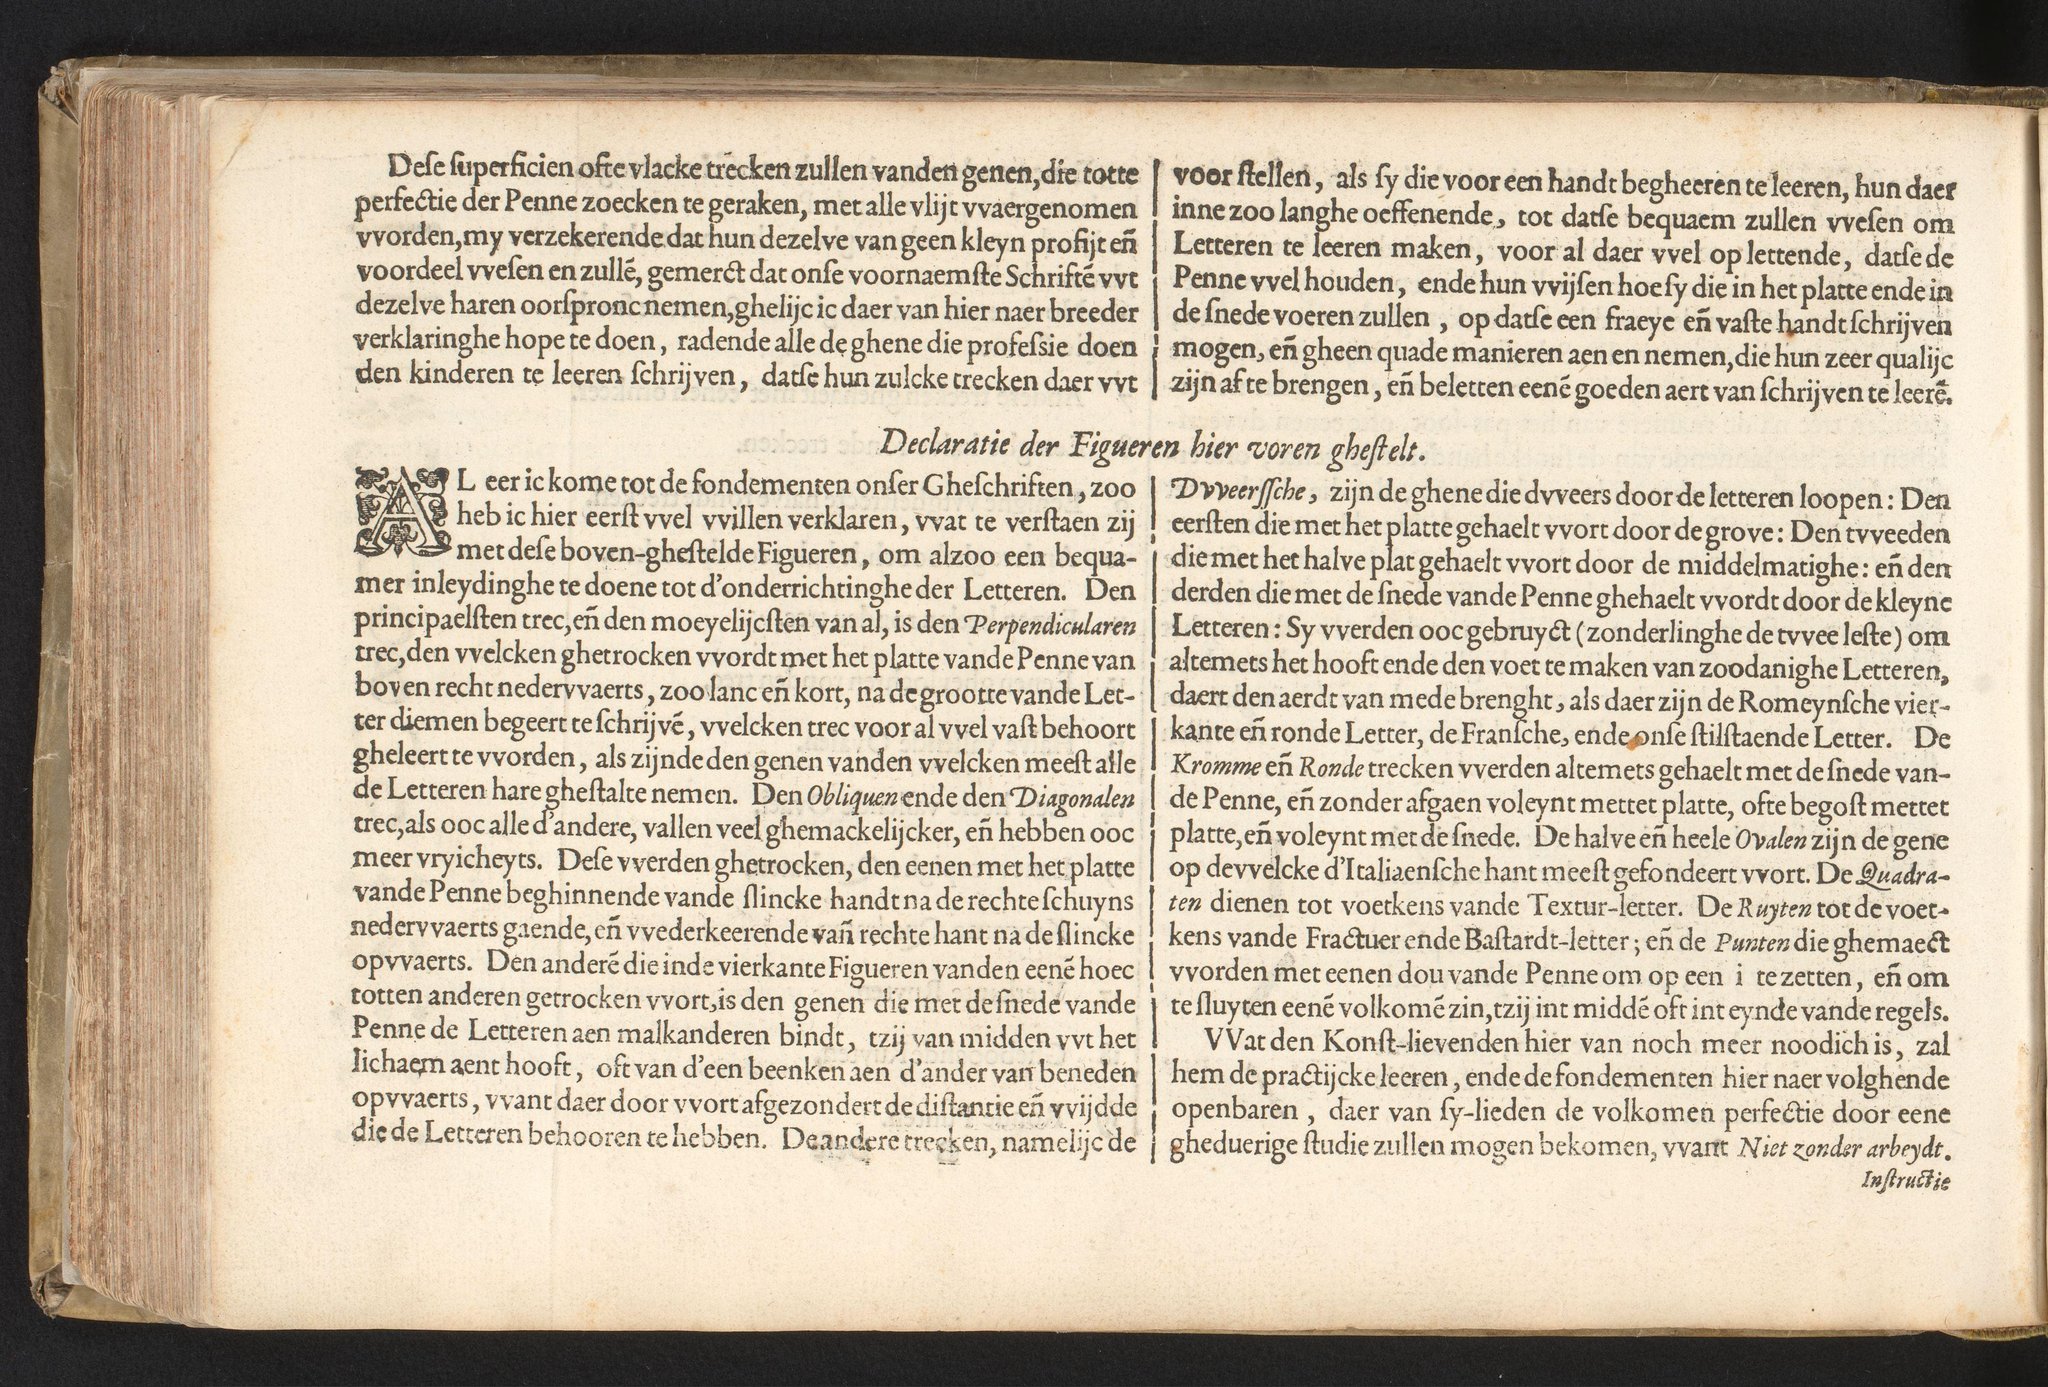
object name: print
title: Fondement-Boeck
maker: jan van de velde (i)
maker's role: painter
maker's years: 1568-1623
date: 1605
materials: paper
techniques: letterpress printing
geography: rotterdam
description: Folio B1v. Instructie hoe de rietpen vastgehouden moet worden (tweede vervolg) met een uitleg van de voorbeelden op de vorige pagina. De tekst vangt aan met een gedecoreerde initiaal A. Het tekstblad maakt deel uit van een album.